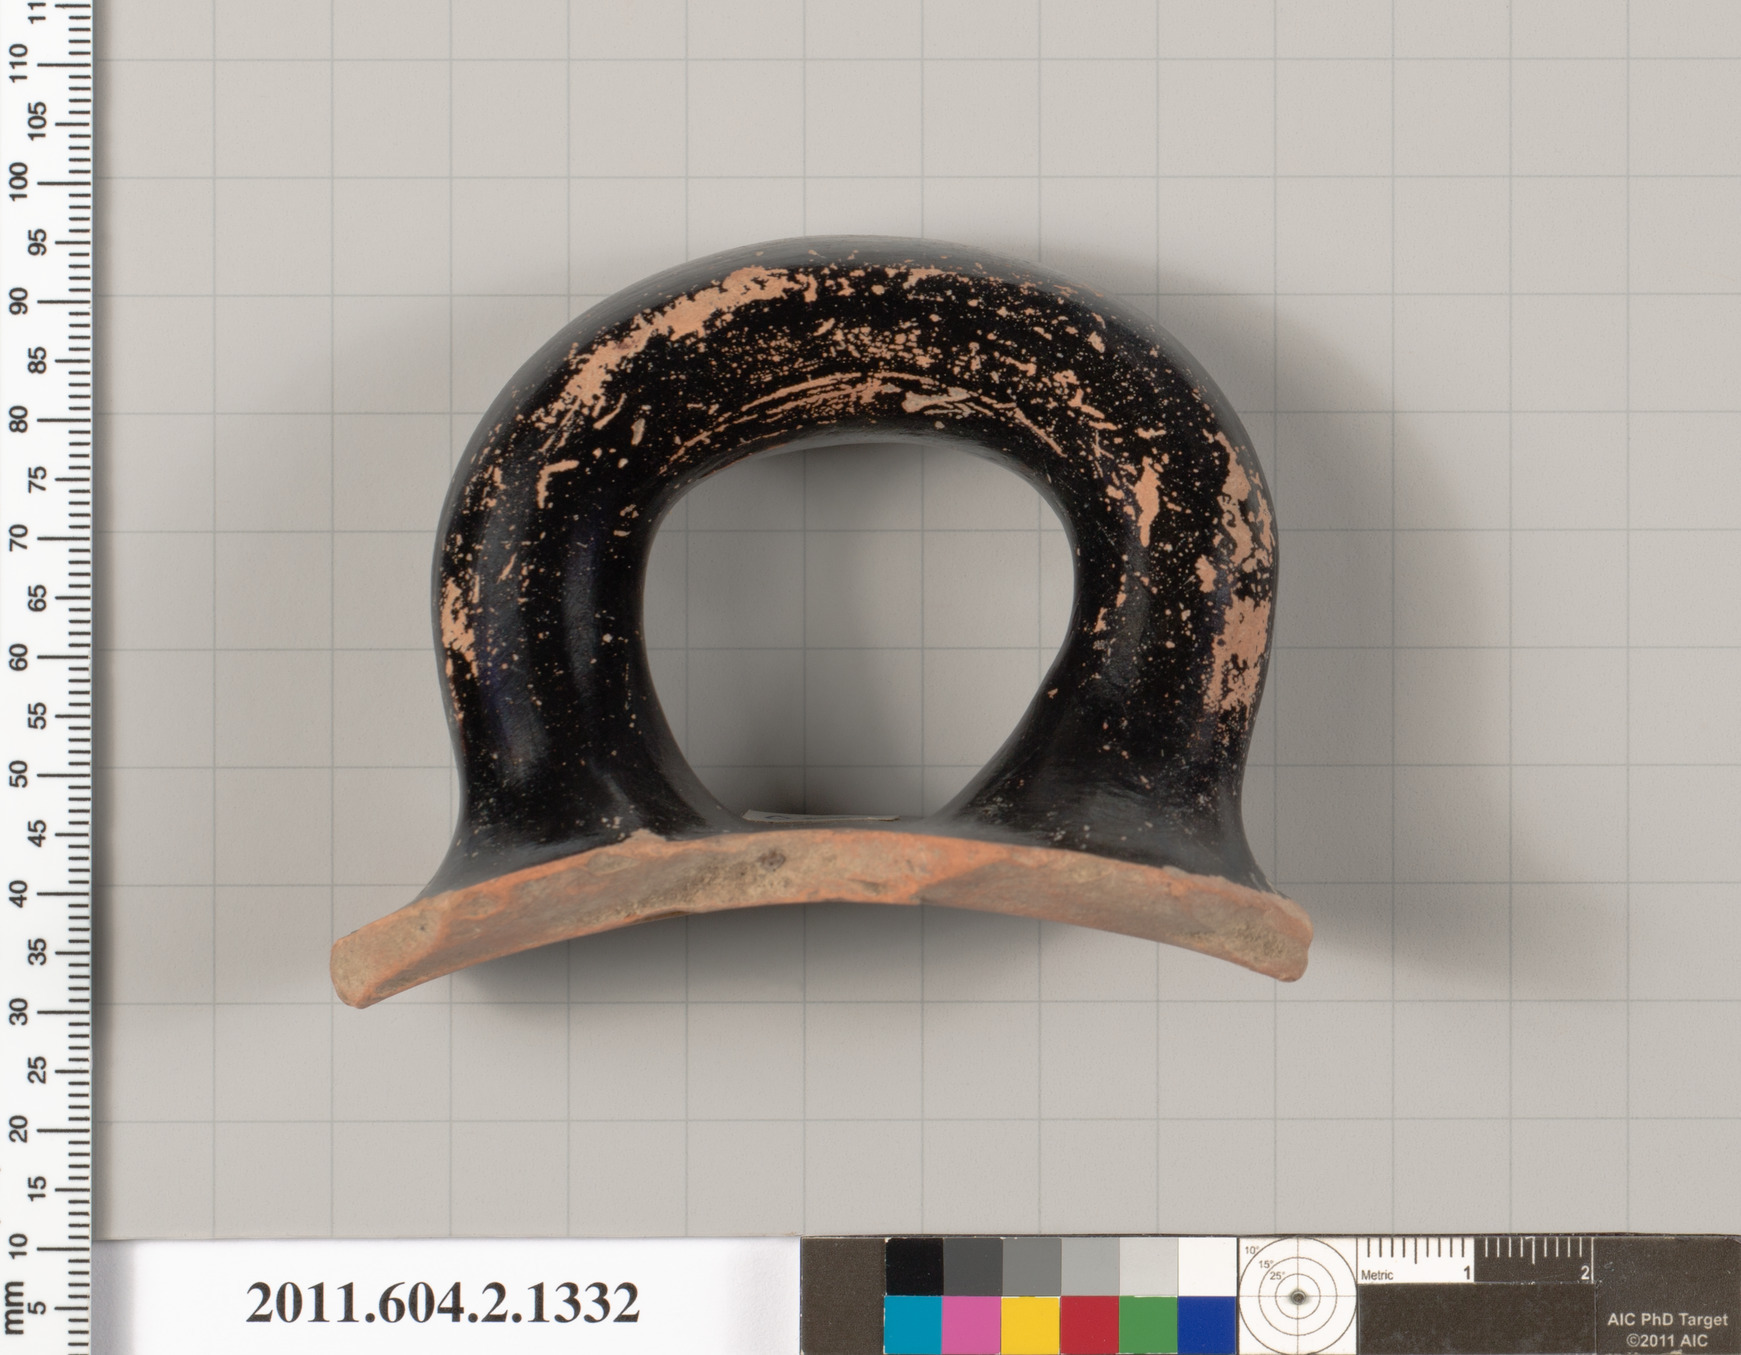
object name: skyphos fragment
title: Terracotta fragment of a skyphos (deep drinking cup)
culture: greek, attic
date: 500-451 BCE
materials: terracotta